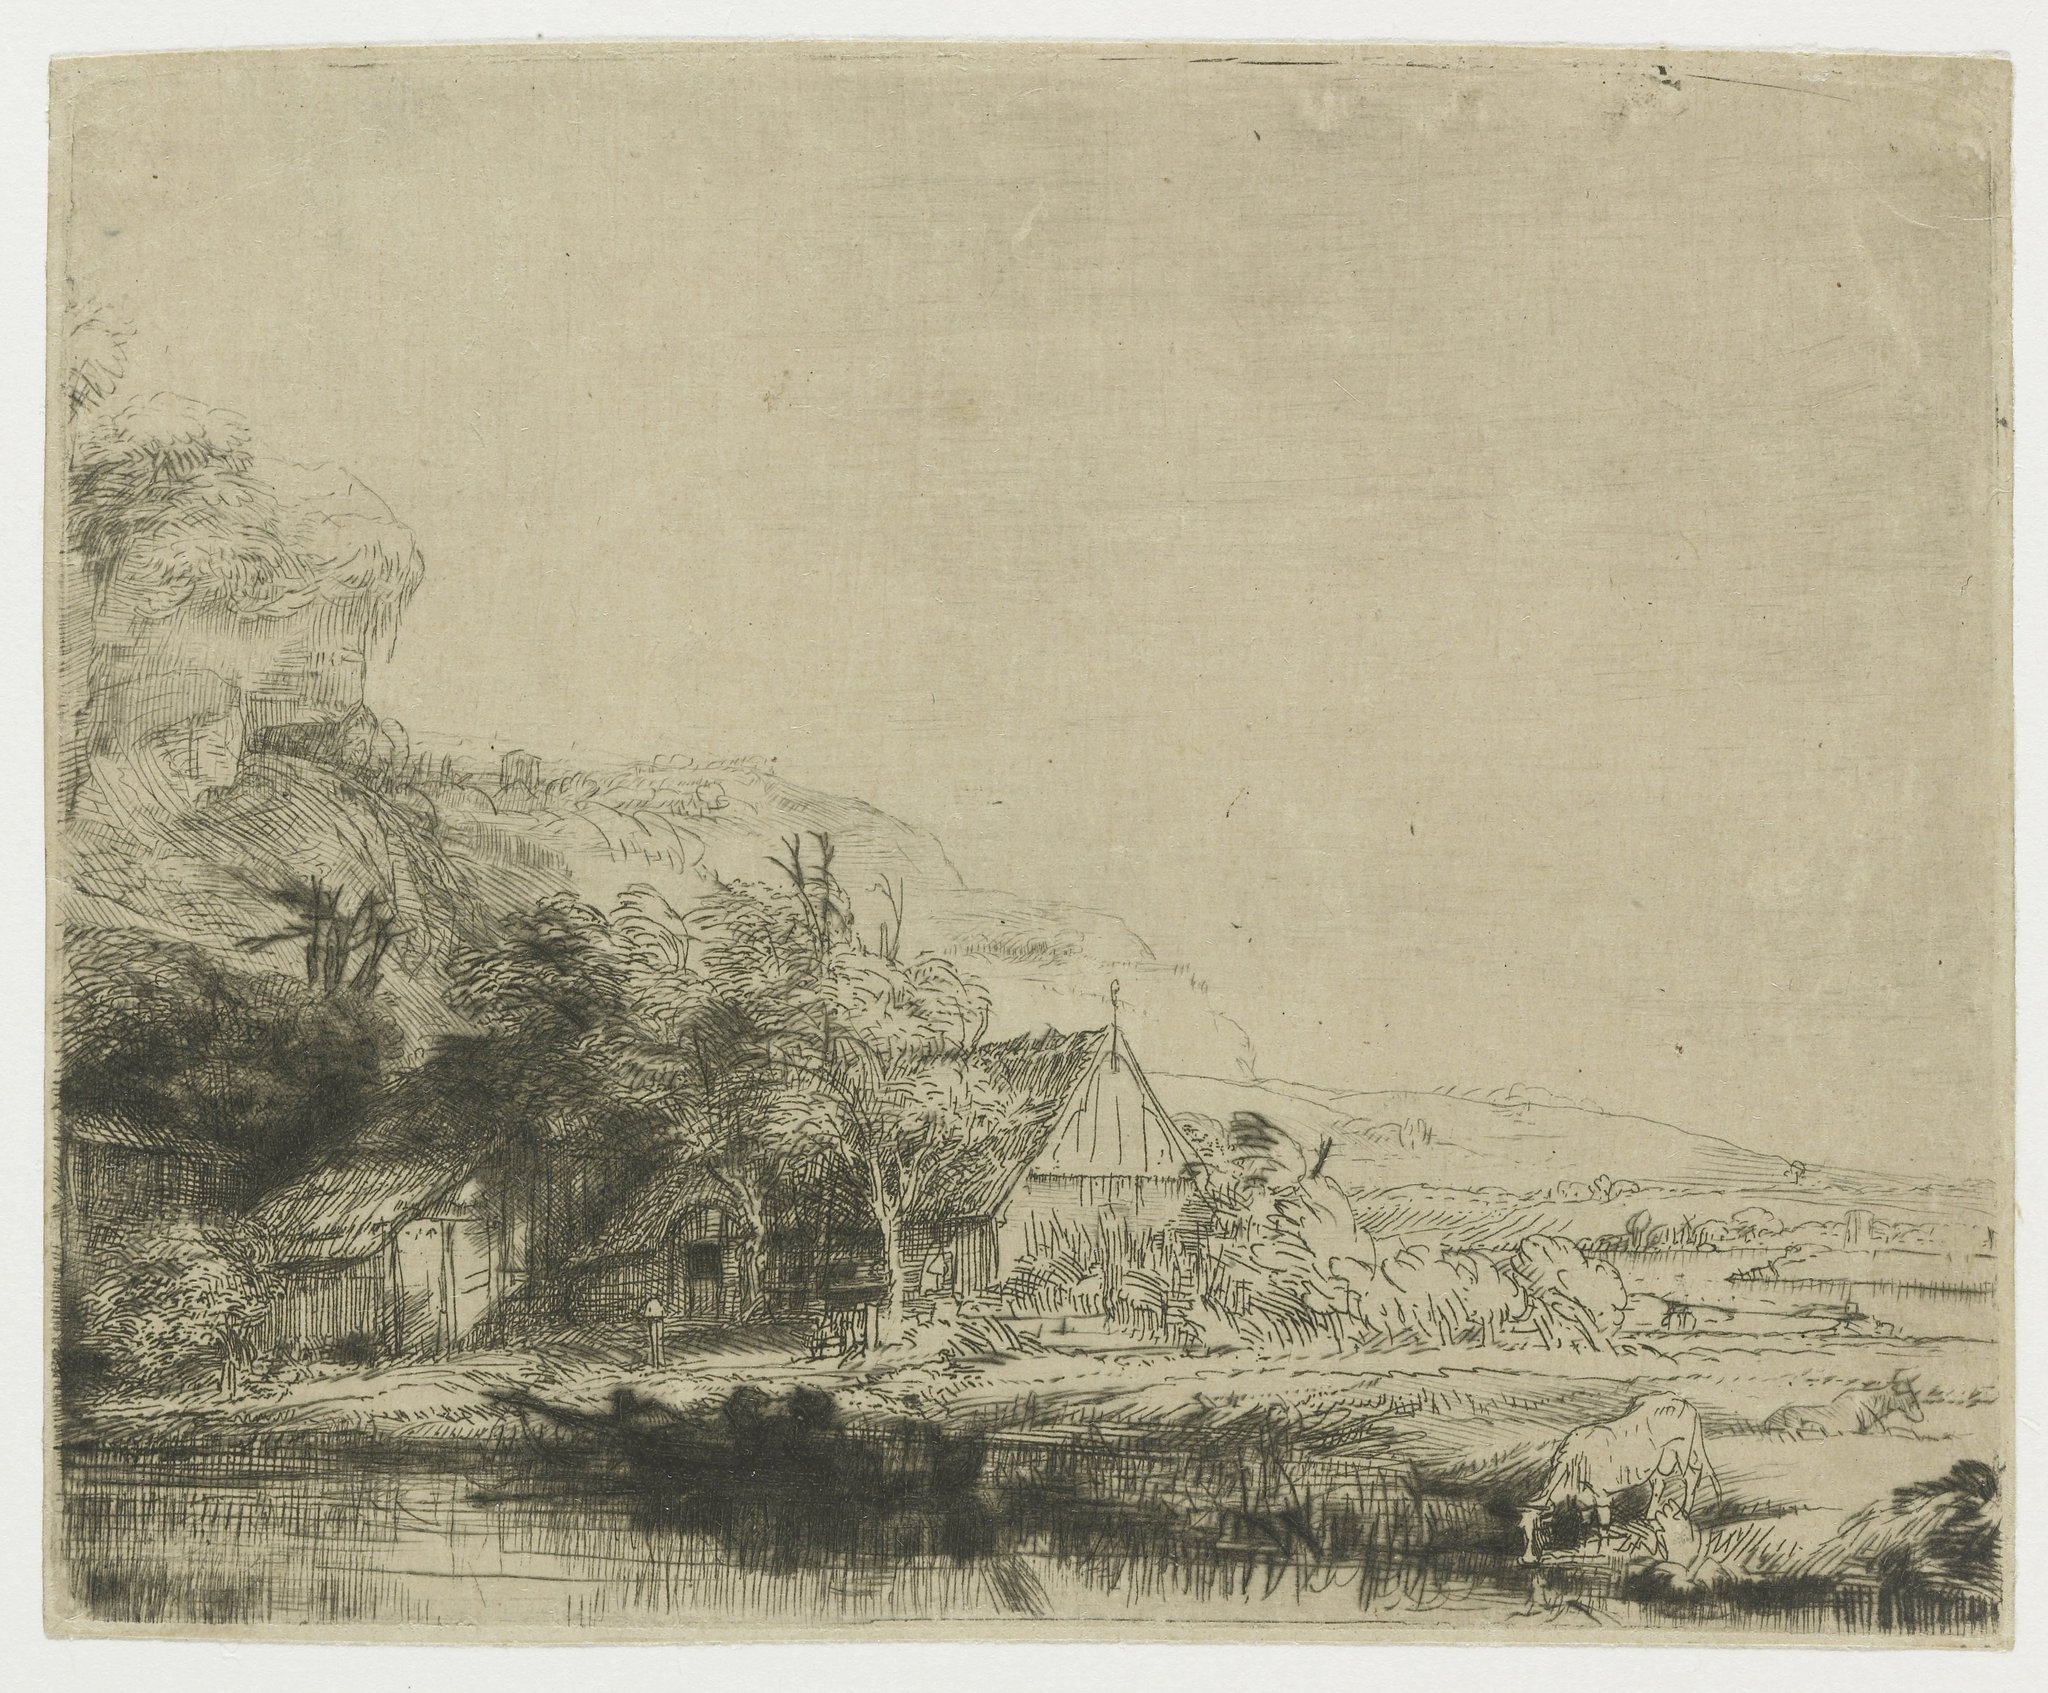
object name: print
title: Landscape with a cow drinking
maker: rembrandt van rijn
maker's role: draughtsman, painter, print maker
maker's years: 1606-1669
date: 1650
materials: paper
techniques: drypoint, etching, intaglio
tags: cow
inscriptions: mark: Lugt 2165